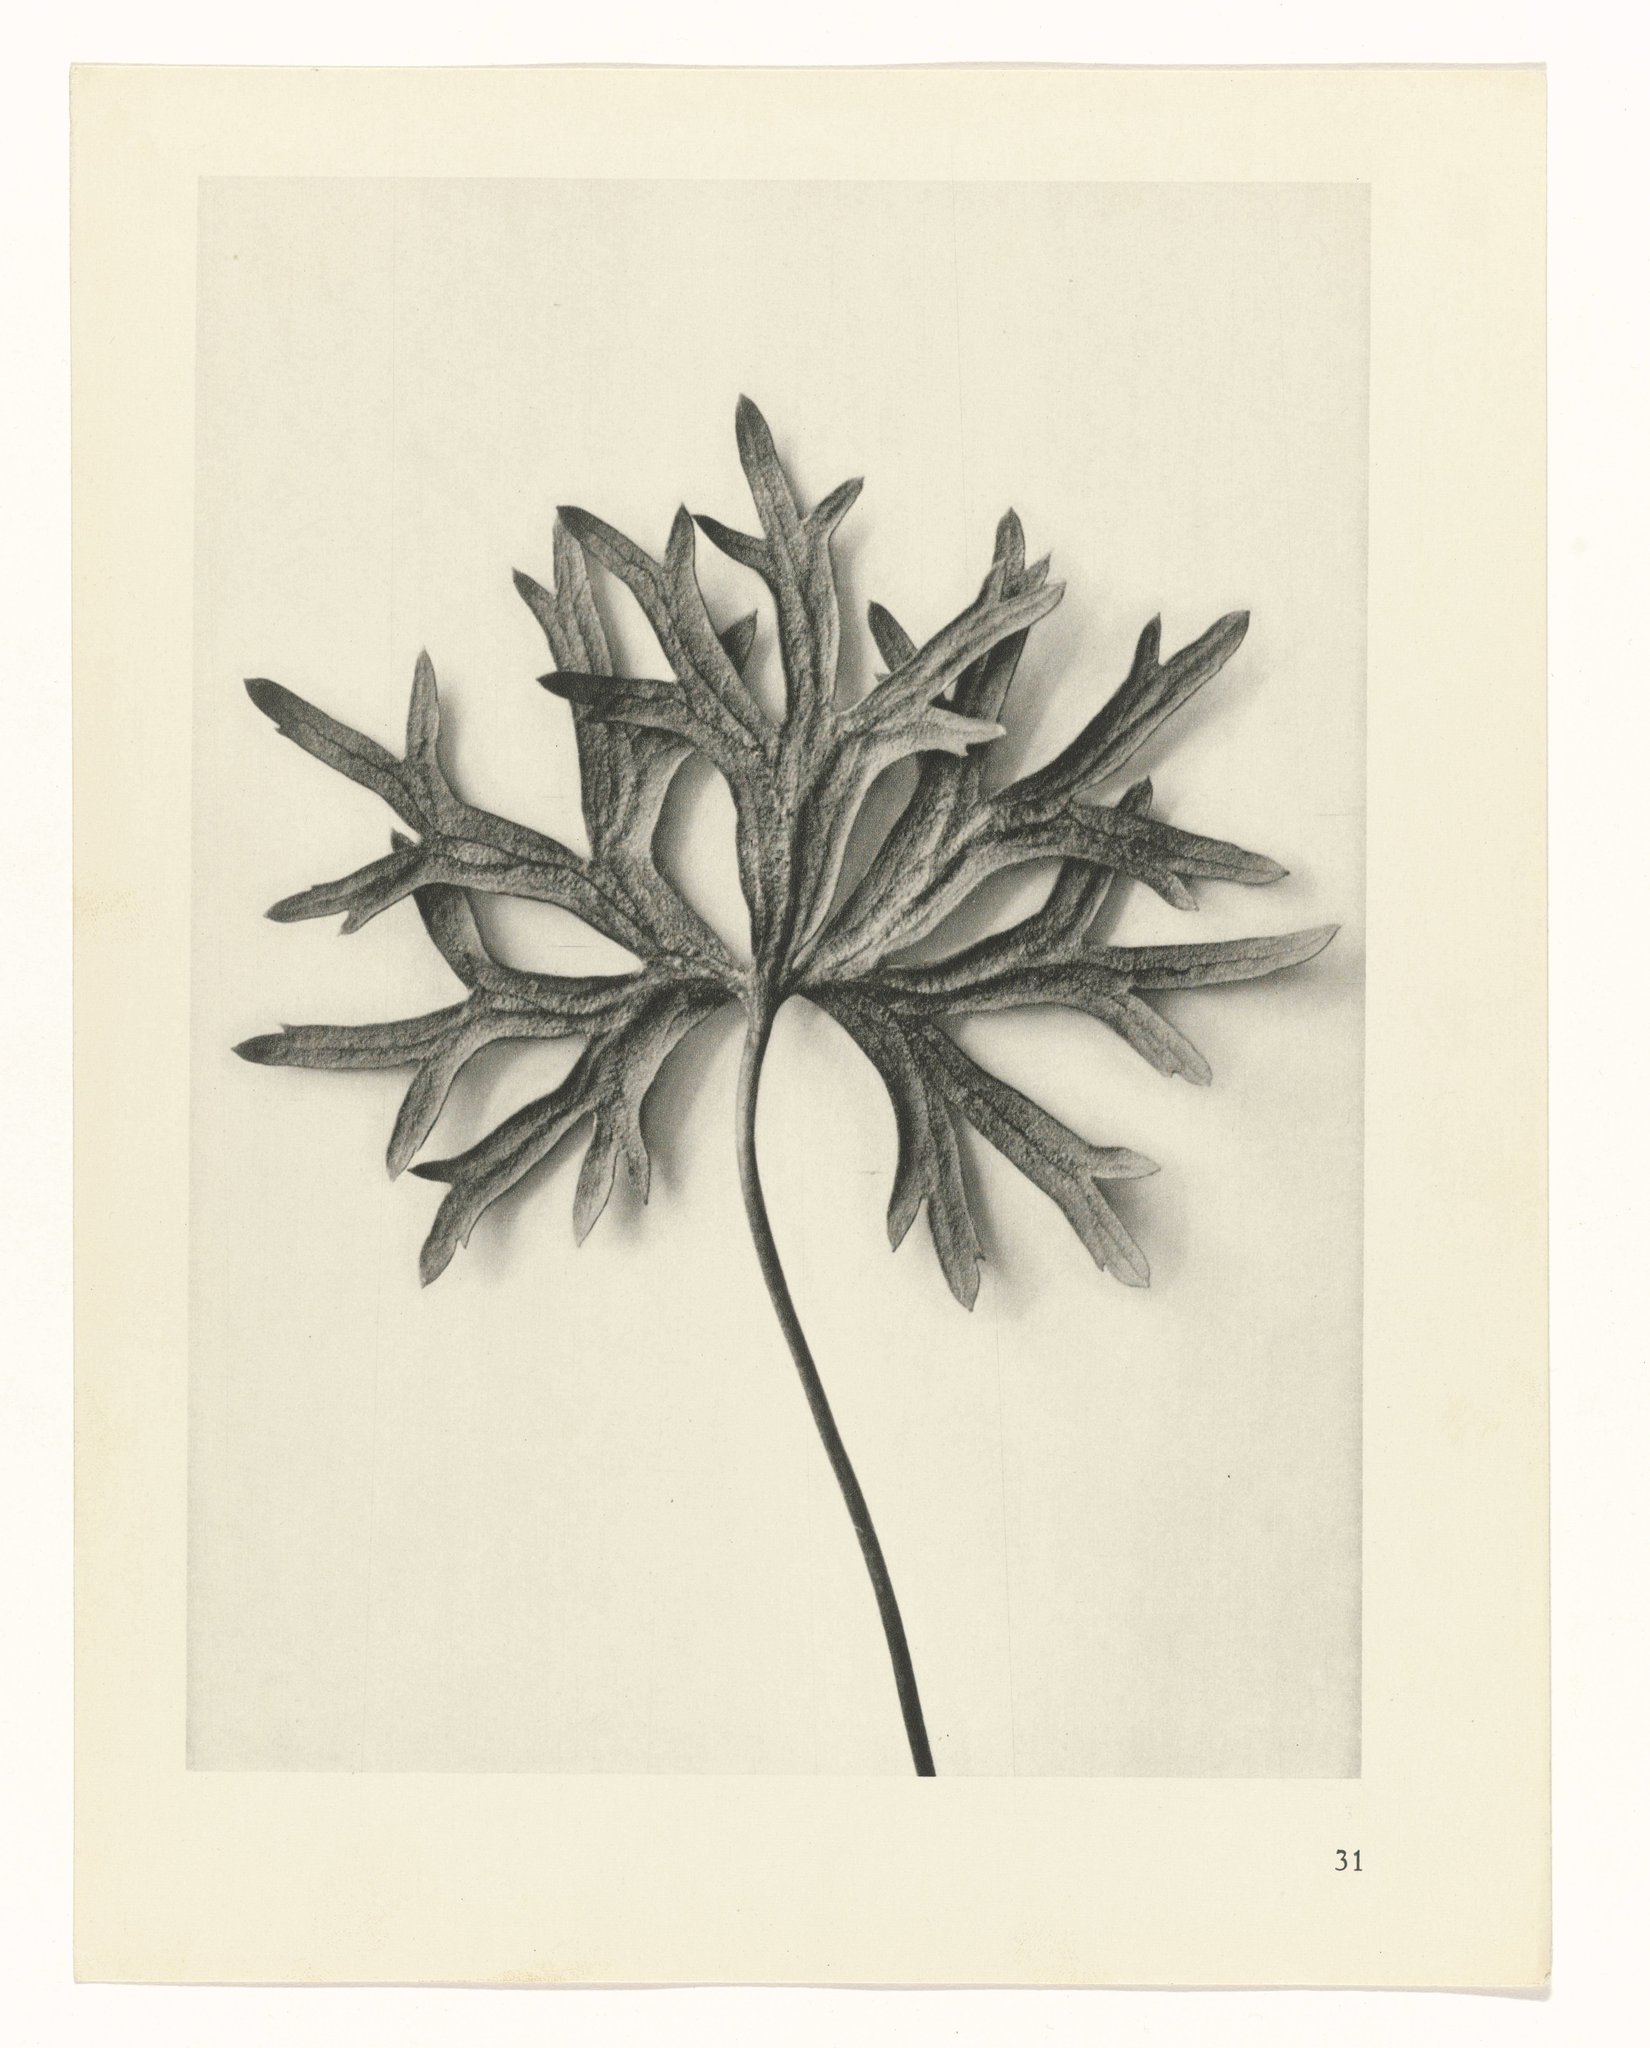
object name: photograph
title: Plant Studies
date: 1928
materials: ink, paper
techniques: rotogravure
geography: berlin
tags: plants (in general)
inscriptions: number: ‘31’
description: facher Vergrößerung. Afkomstig uit losbladige uitgave.